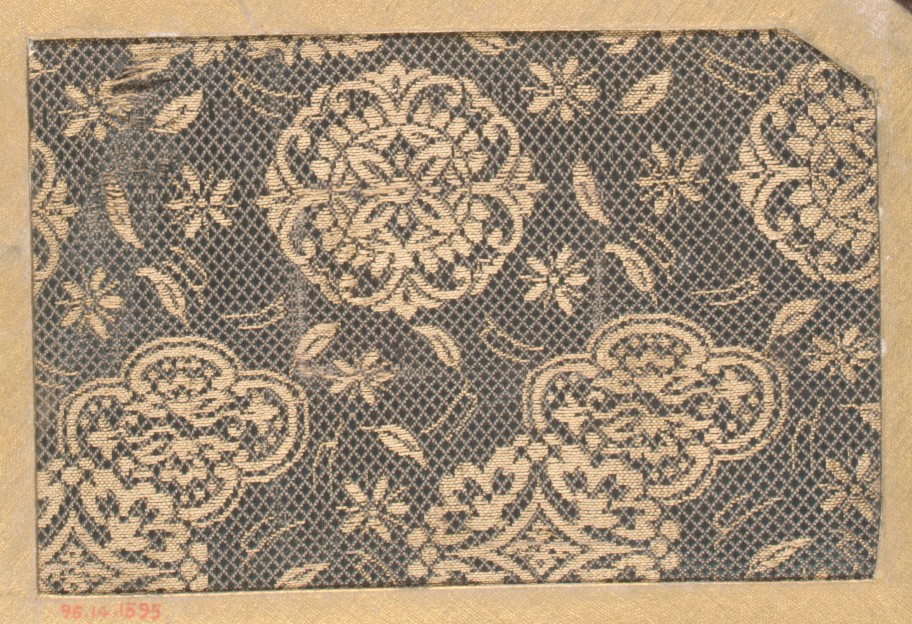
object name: piece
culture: japanese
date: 1701-1900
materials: silk